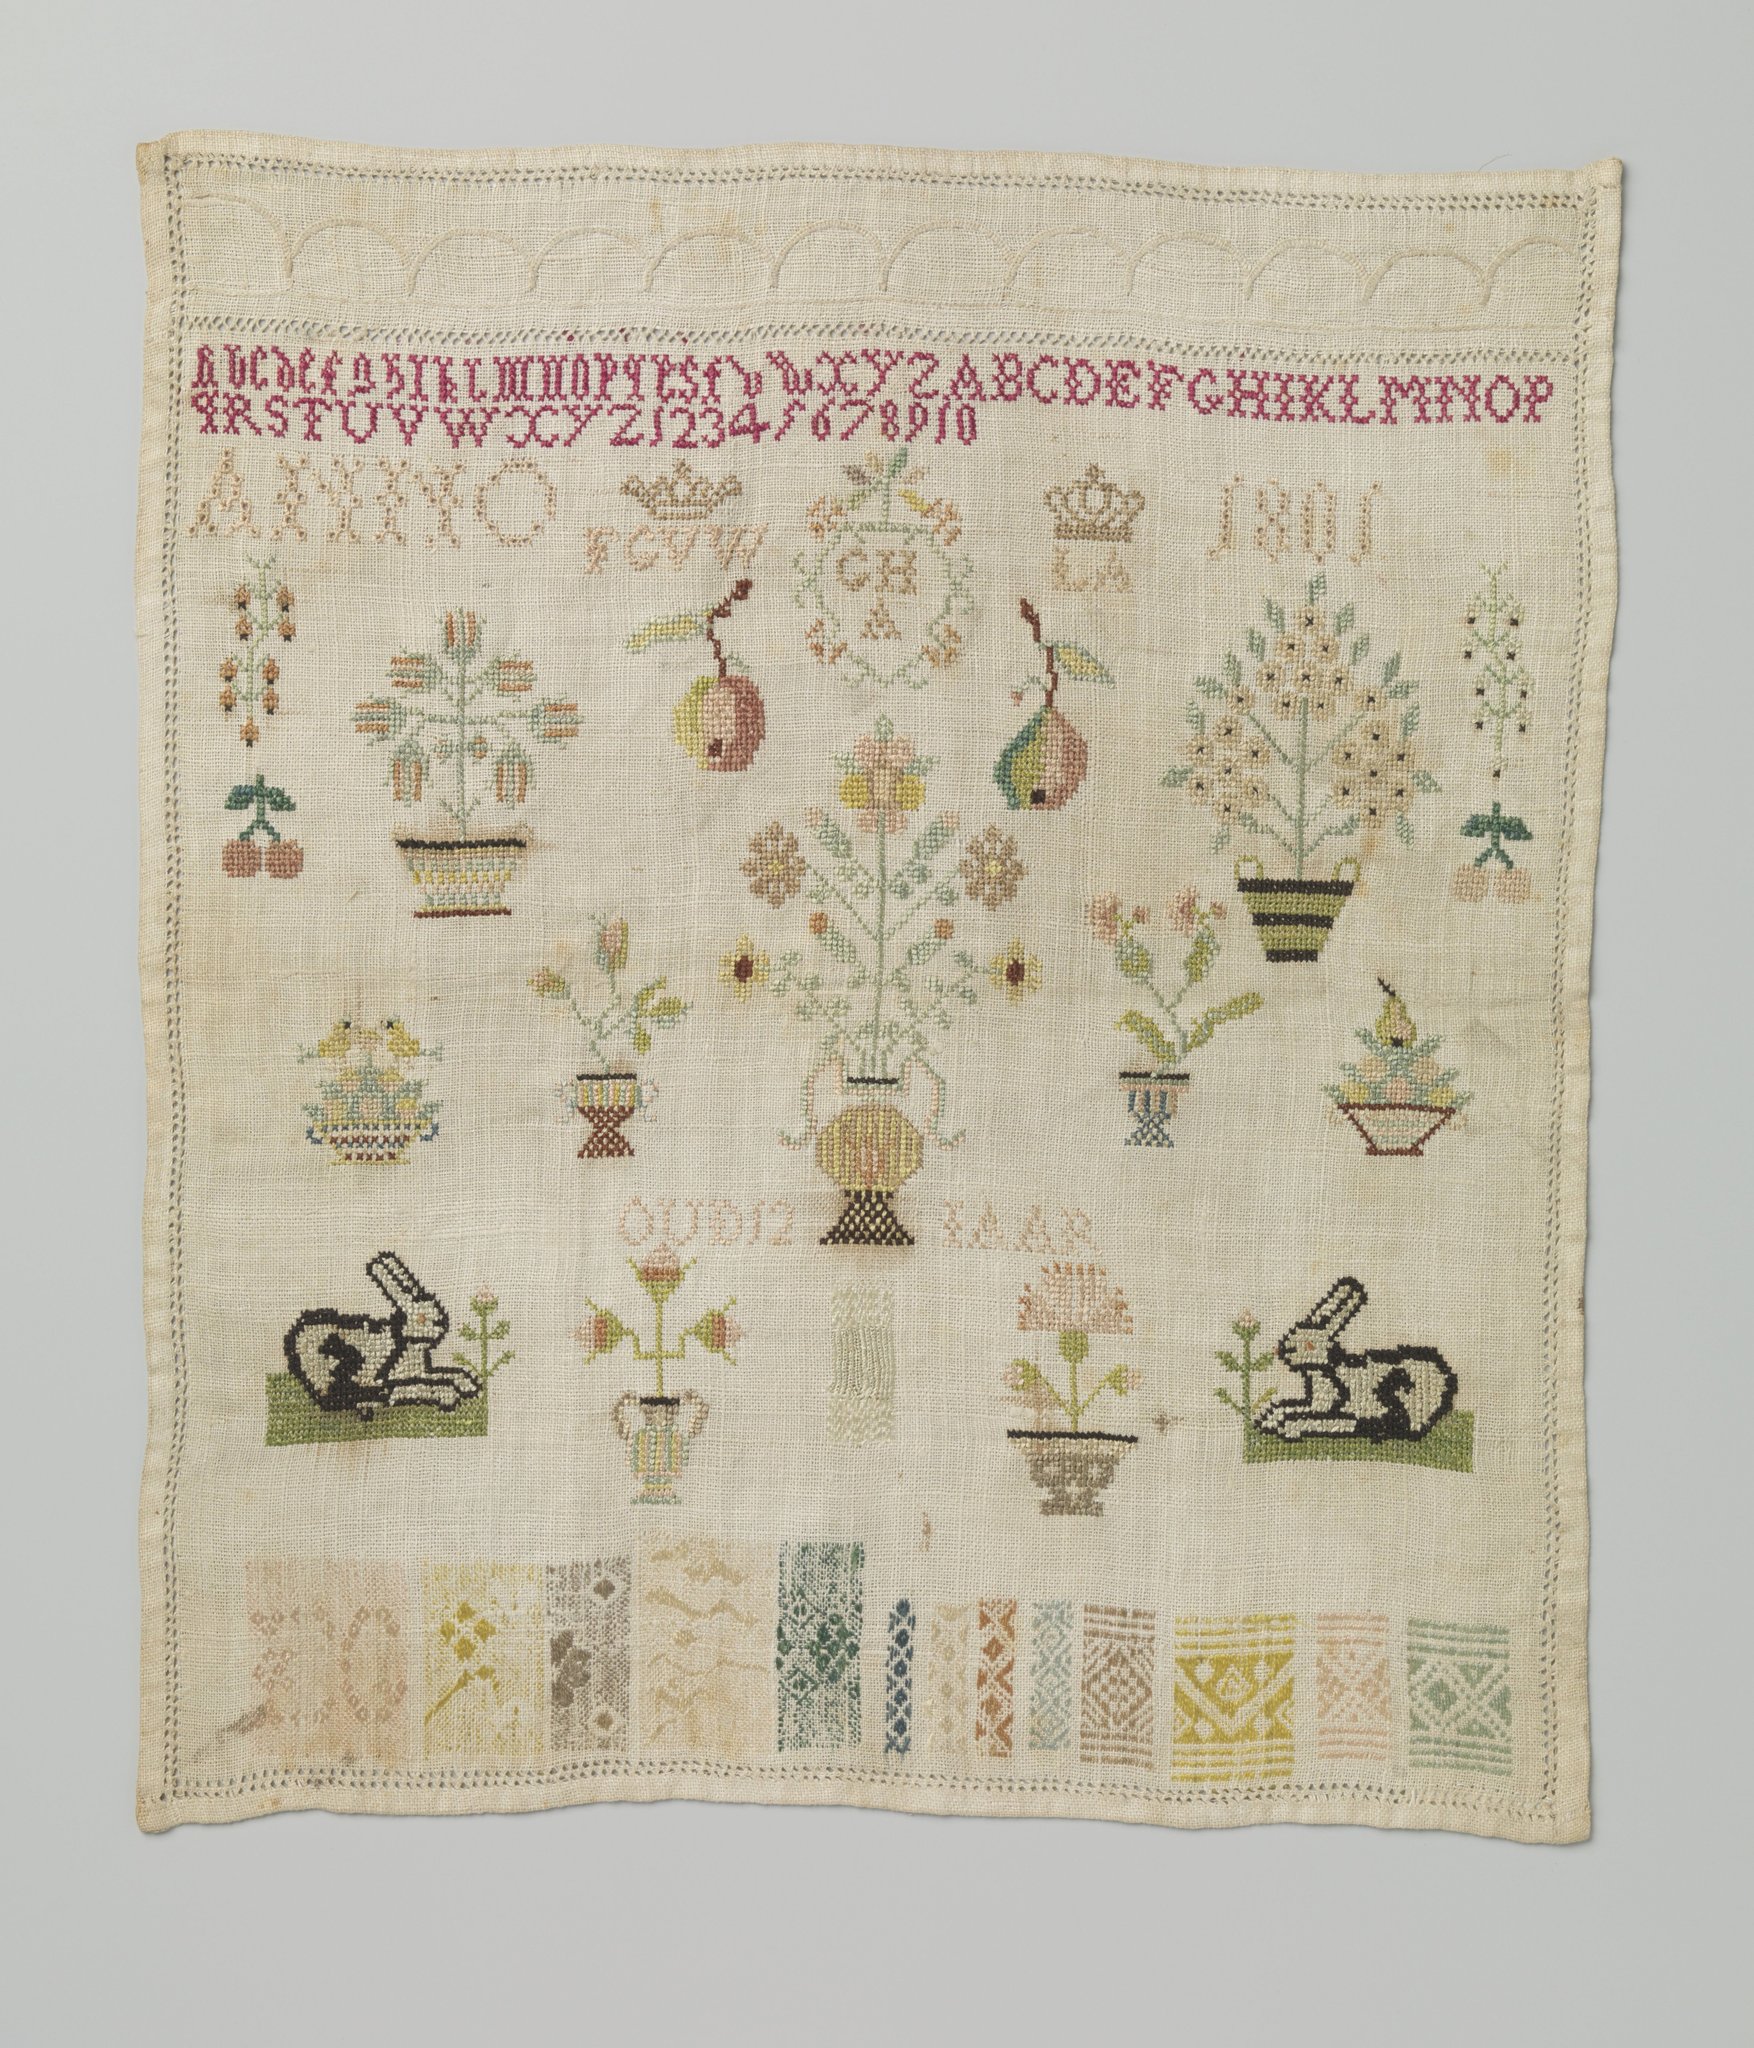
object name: stoplap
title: Merklap van linnen waarop in kruis- en stersteek met veelkleurige zijde een merklapgedeelte met ANNO 1801 en drie paar initialen, 13 doorstoppen in satijn- en keperbindingen waarbij één met initialen.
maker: gha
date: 1801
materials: linen, silk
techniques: embroidered, weave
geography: amsterdam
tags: amsterdam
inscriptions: date: ‘ANNO1801’, initials: ‘GHA, LA, FGVW, EG’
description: Alfabet doet denken aan het werk uit een instelling. Ook het combineren van merk- en stoplap op een doek. Misschien het Burgerweeshuis in Amsterdam? Techniek: kruissteek en enkele stersteek (om linnen te merken), festonsteek voor de bogen, kelim midden onder de vaas, doorstop links onder EG (mogelijk de handwerklerares) keper- en satijnbinding doorstop. Dubbele open zoom met linnen garen.